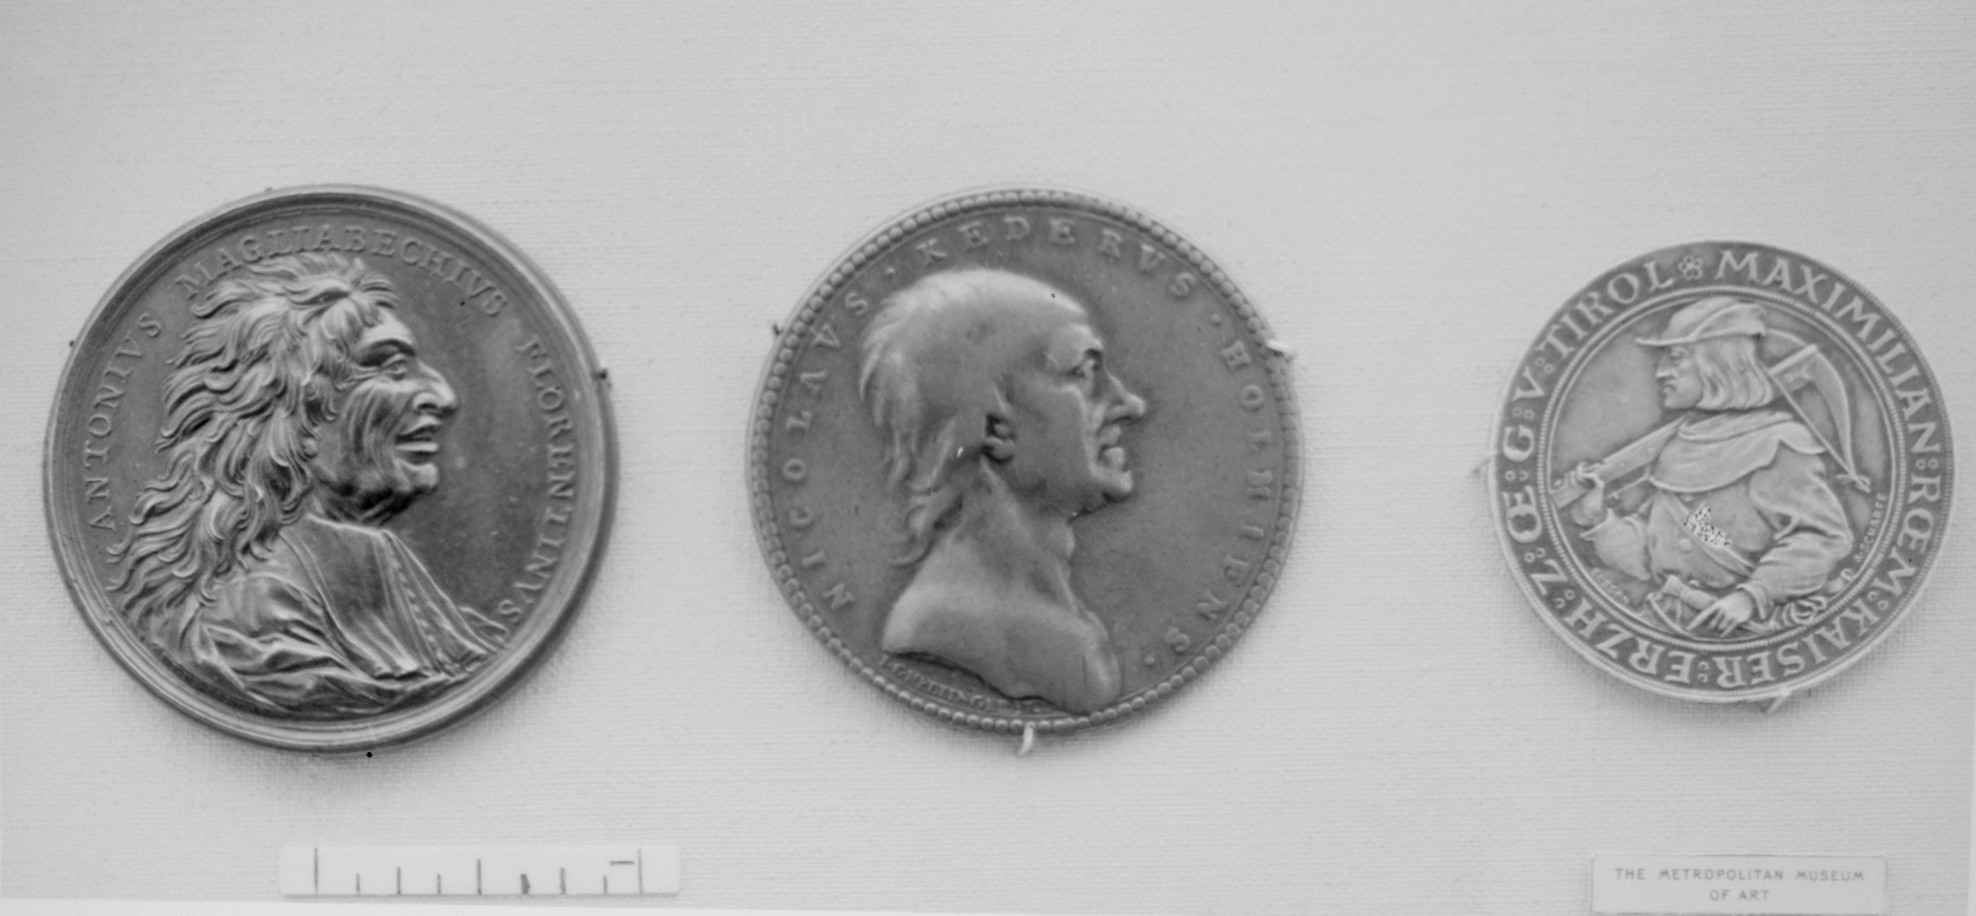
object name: medal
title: The second Austrian Shooting-match at Innsbruck, 1885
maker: b. arnold busson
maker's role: artist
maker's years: 1844-1892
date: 1885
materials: silver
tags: men,profiles